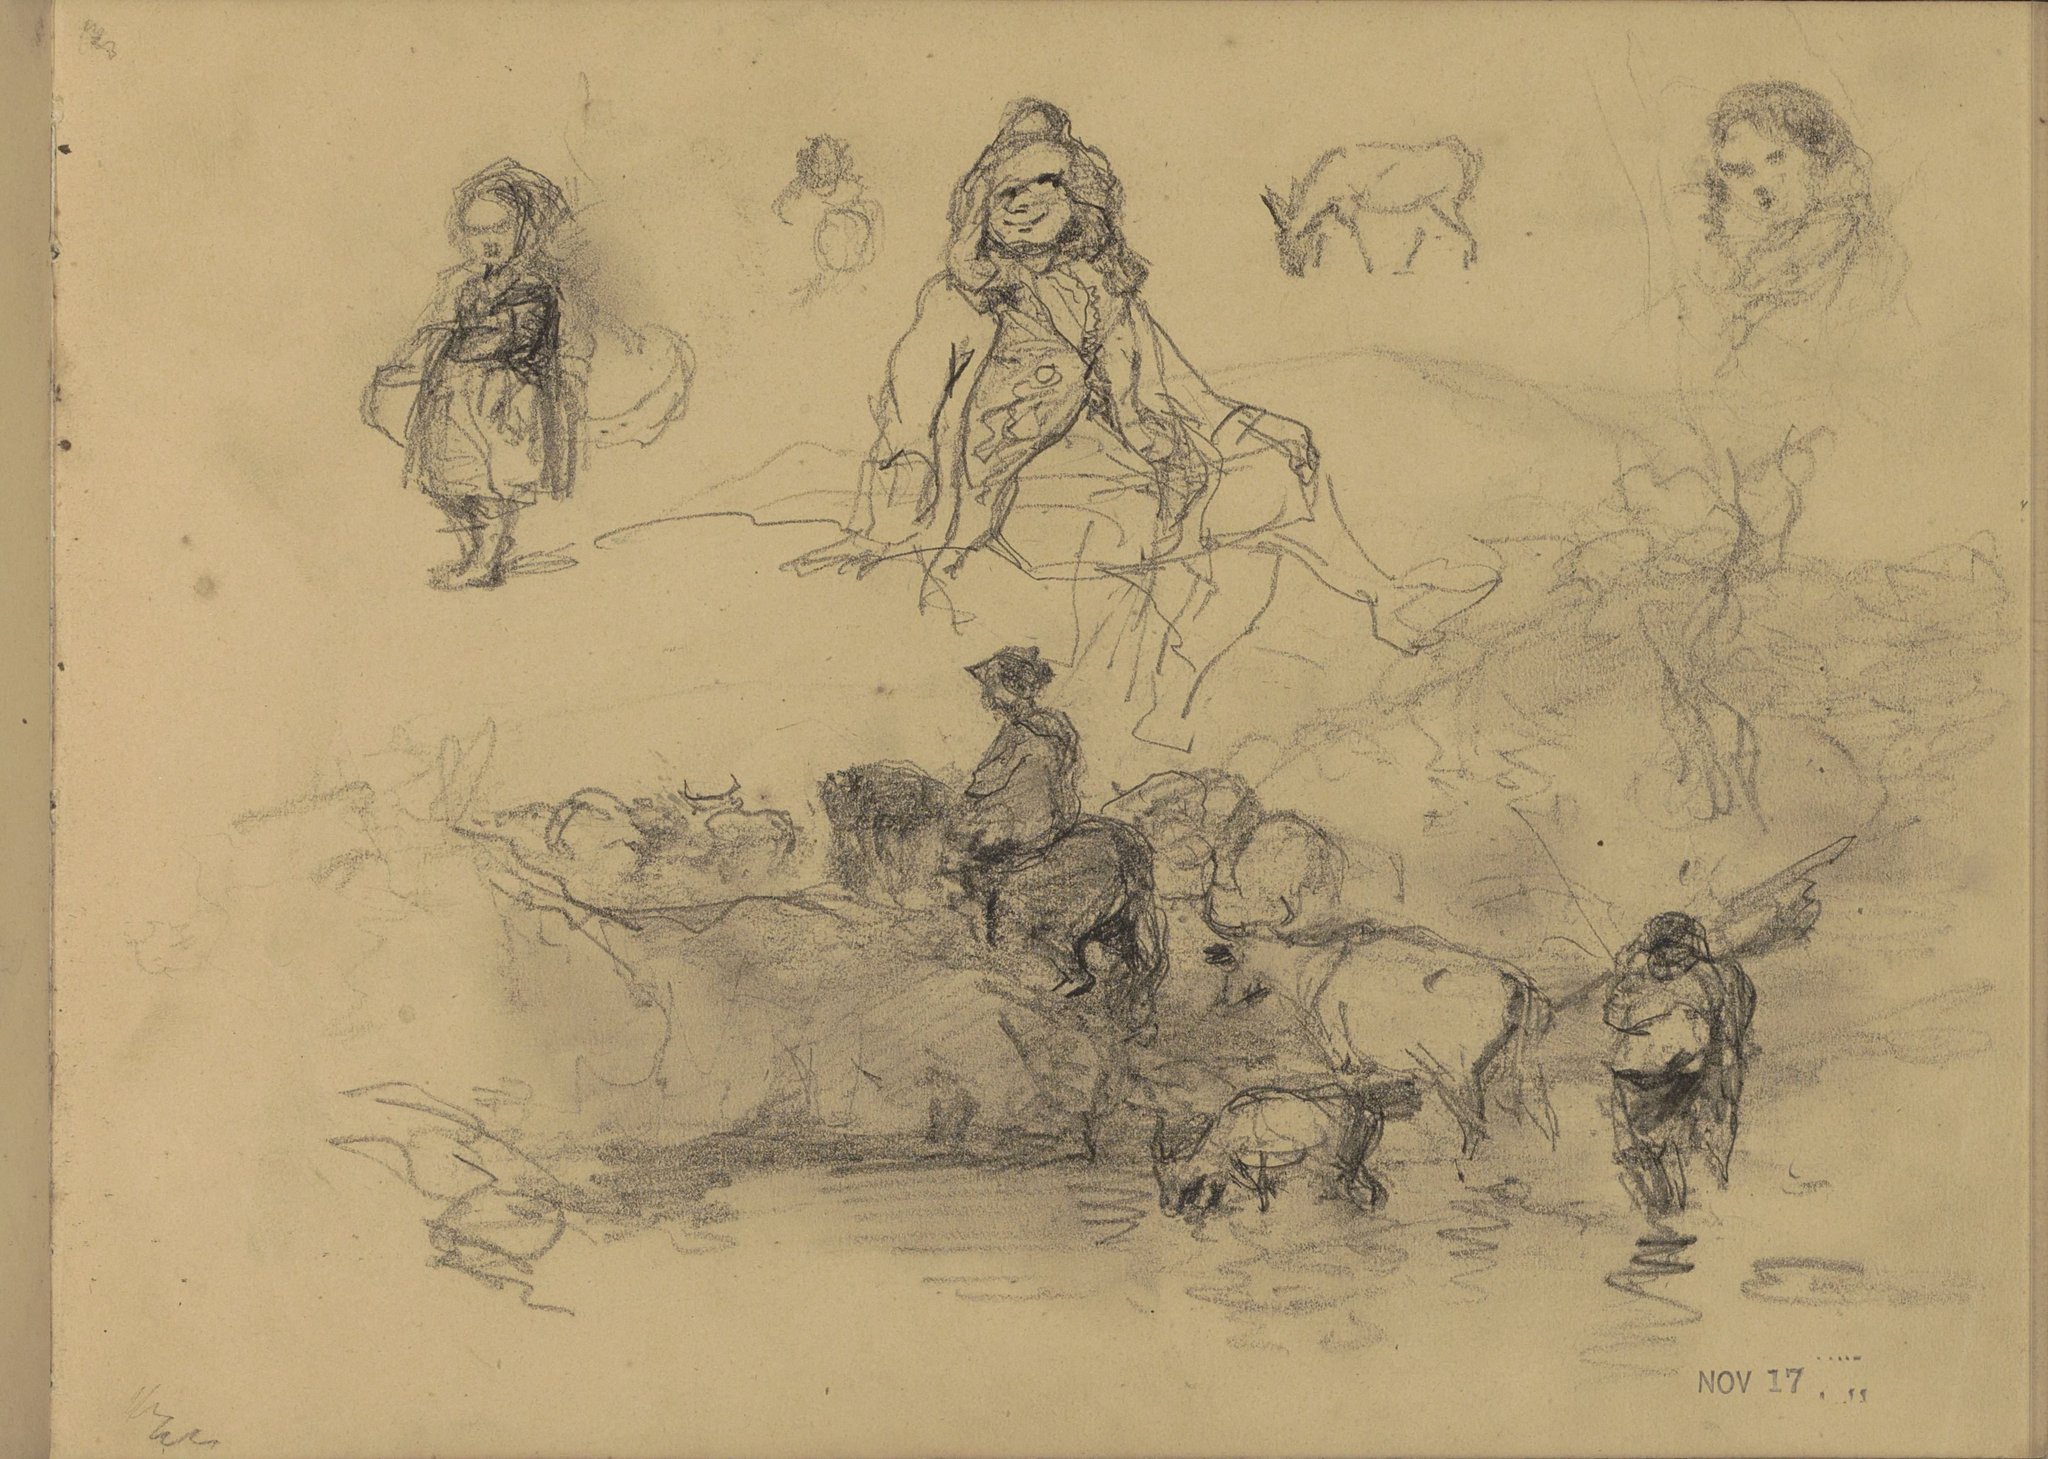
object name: sketchbook leaf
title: Studieblad met kinderen, dieren en een waterplaats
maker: willem roelofs (i)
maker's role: draughtsman, painter, print maker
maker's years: 1822-1897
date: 1846-1851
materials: paper, pencil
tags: cattle, child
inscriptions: date: ‘NOV 17 , ,,’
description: Blad 11 recto uit een schetsboek met 25 bladen.